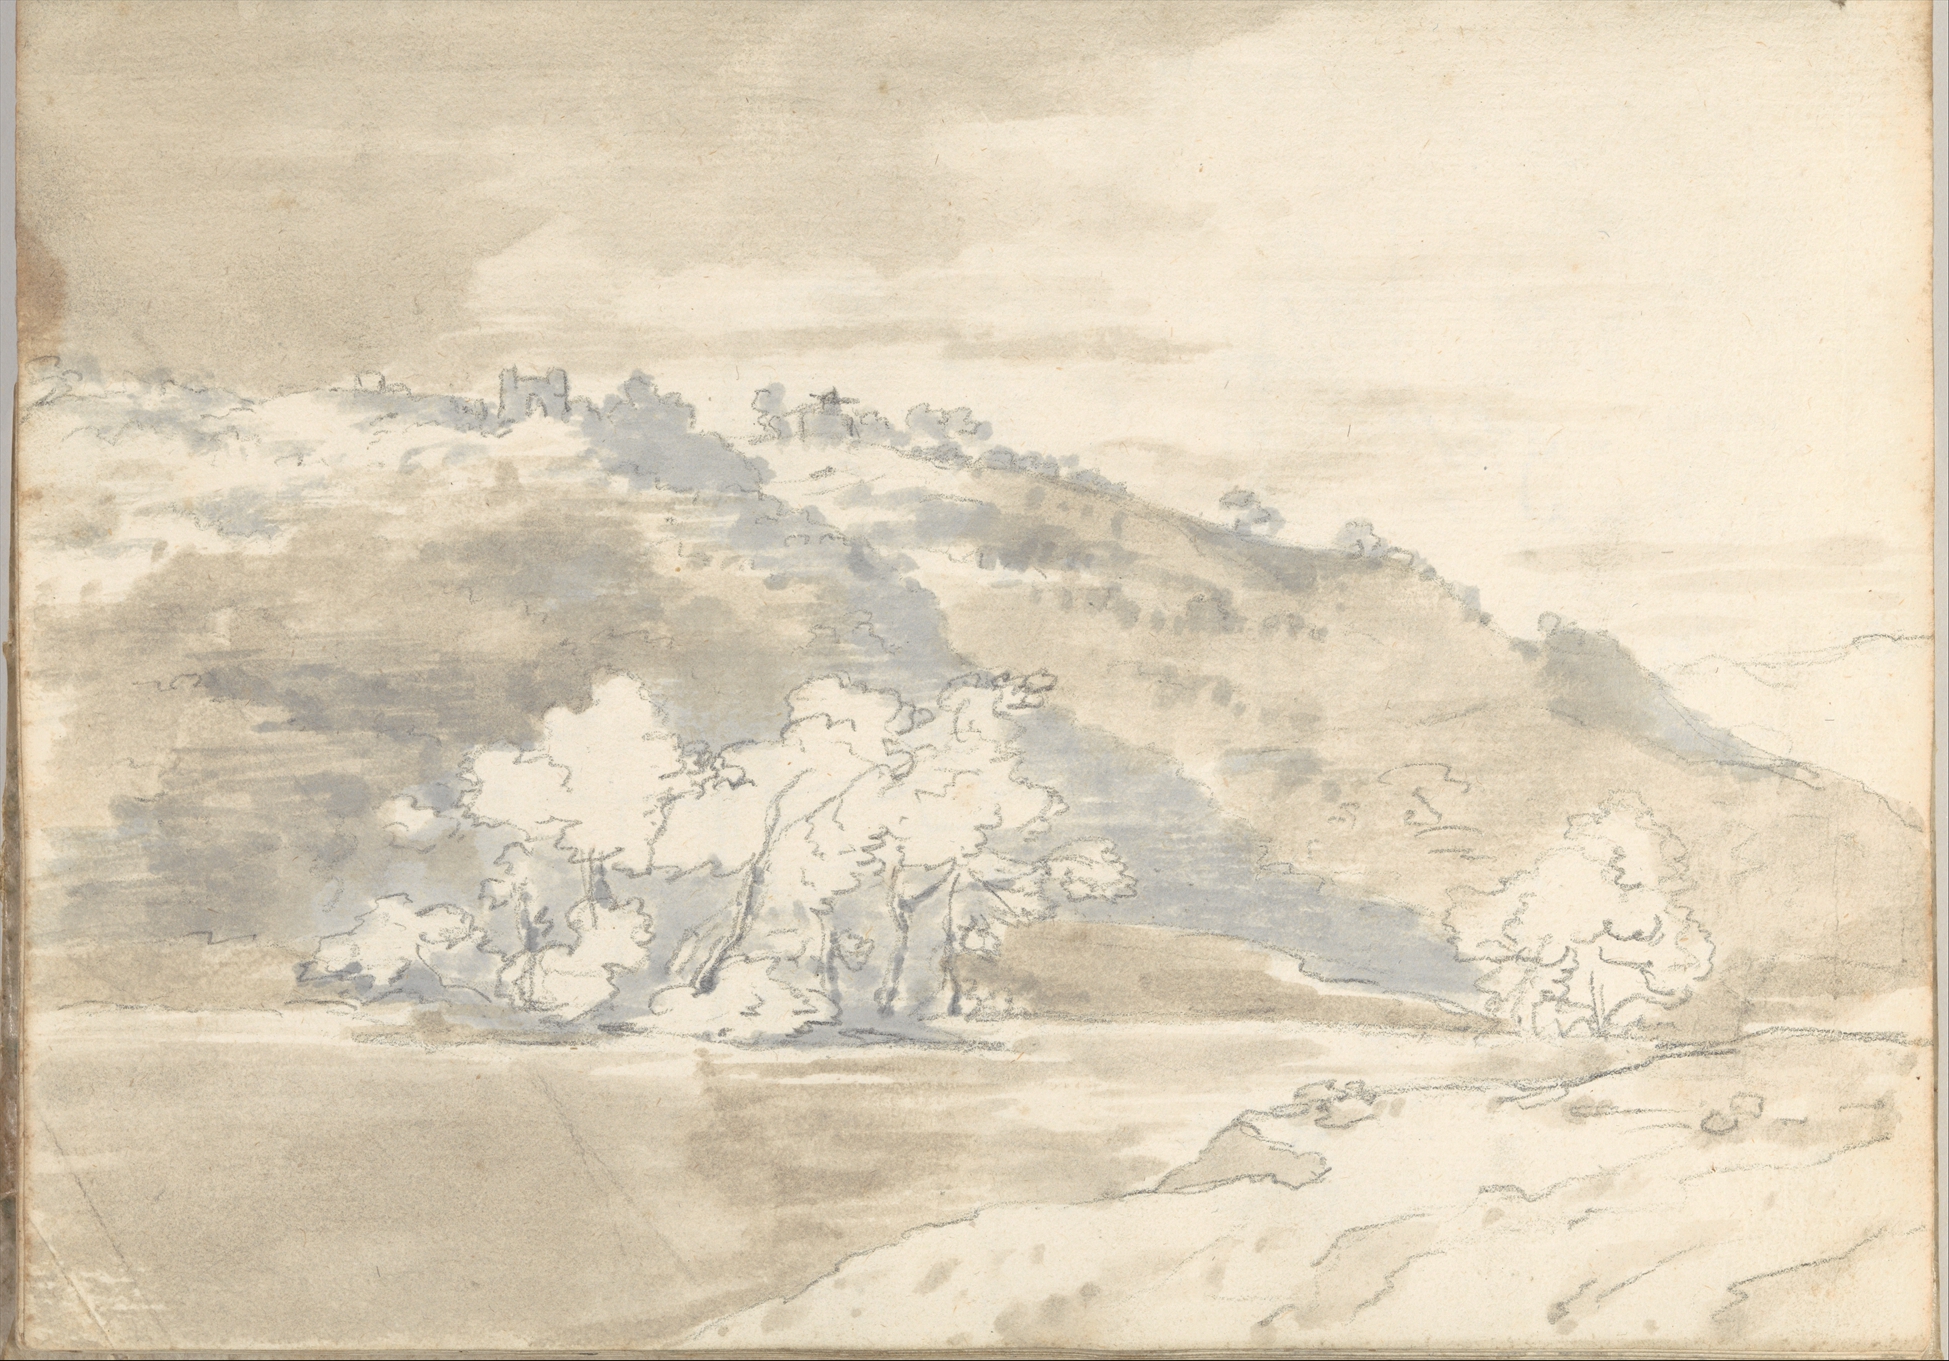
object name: drawing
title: Upon the Tiber, near Rome (Smaller Italian sketchbook, leaf 33 recto)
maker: joseph wright (wright of derby)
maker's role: artist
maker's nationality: british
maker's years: 1734-1797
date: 1774-1775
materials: graphite, ink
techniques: brush, pen, wash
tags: buildings,hills,landscapes